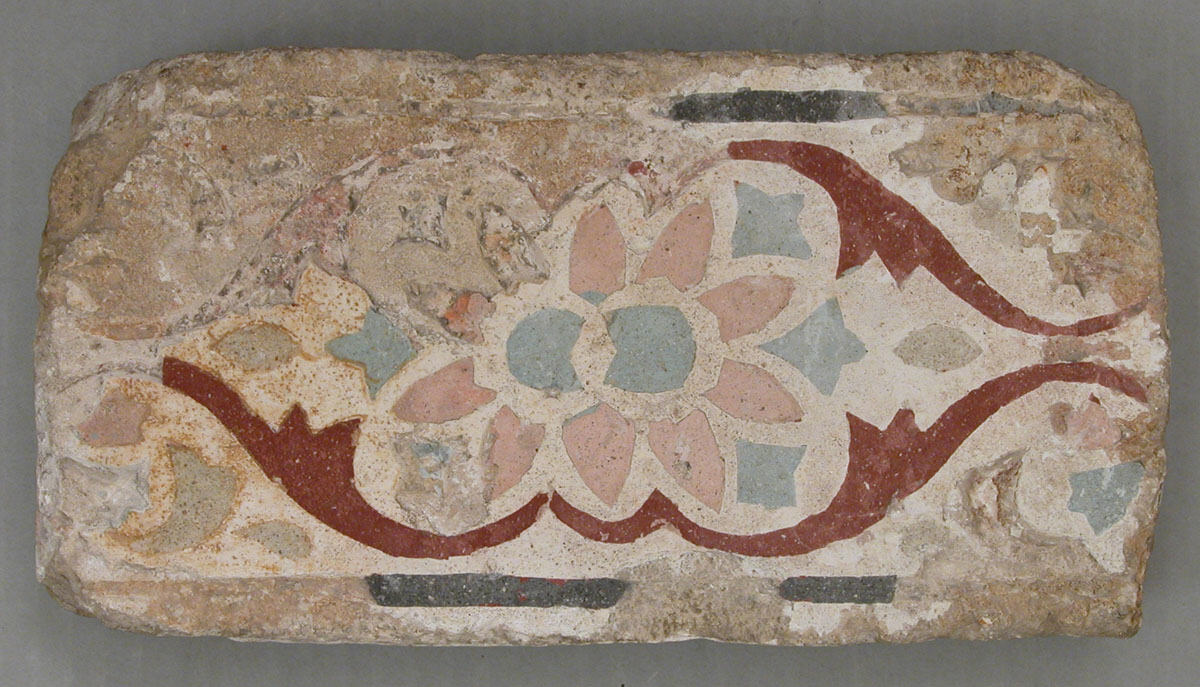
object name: tile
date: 1101-1400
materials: earthenware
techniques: glazing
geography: egypt